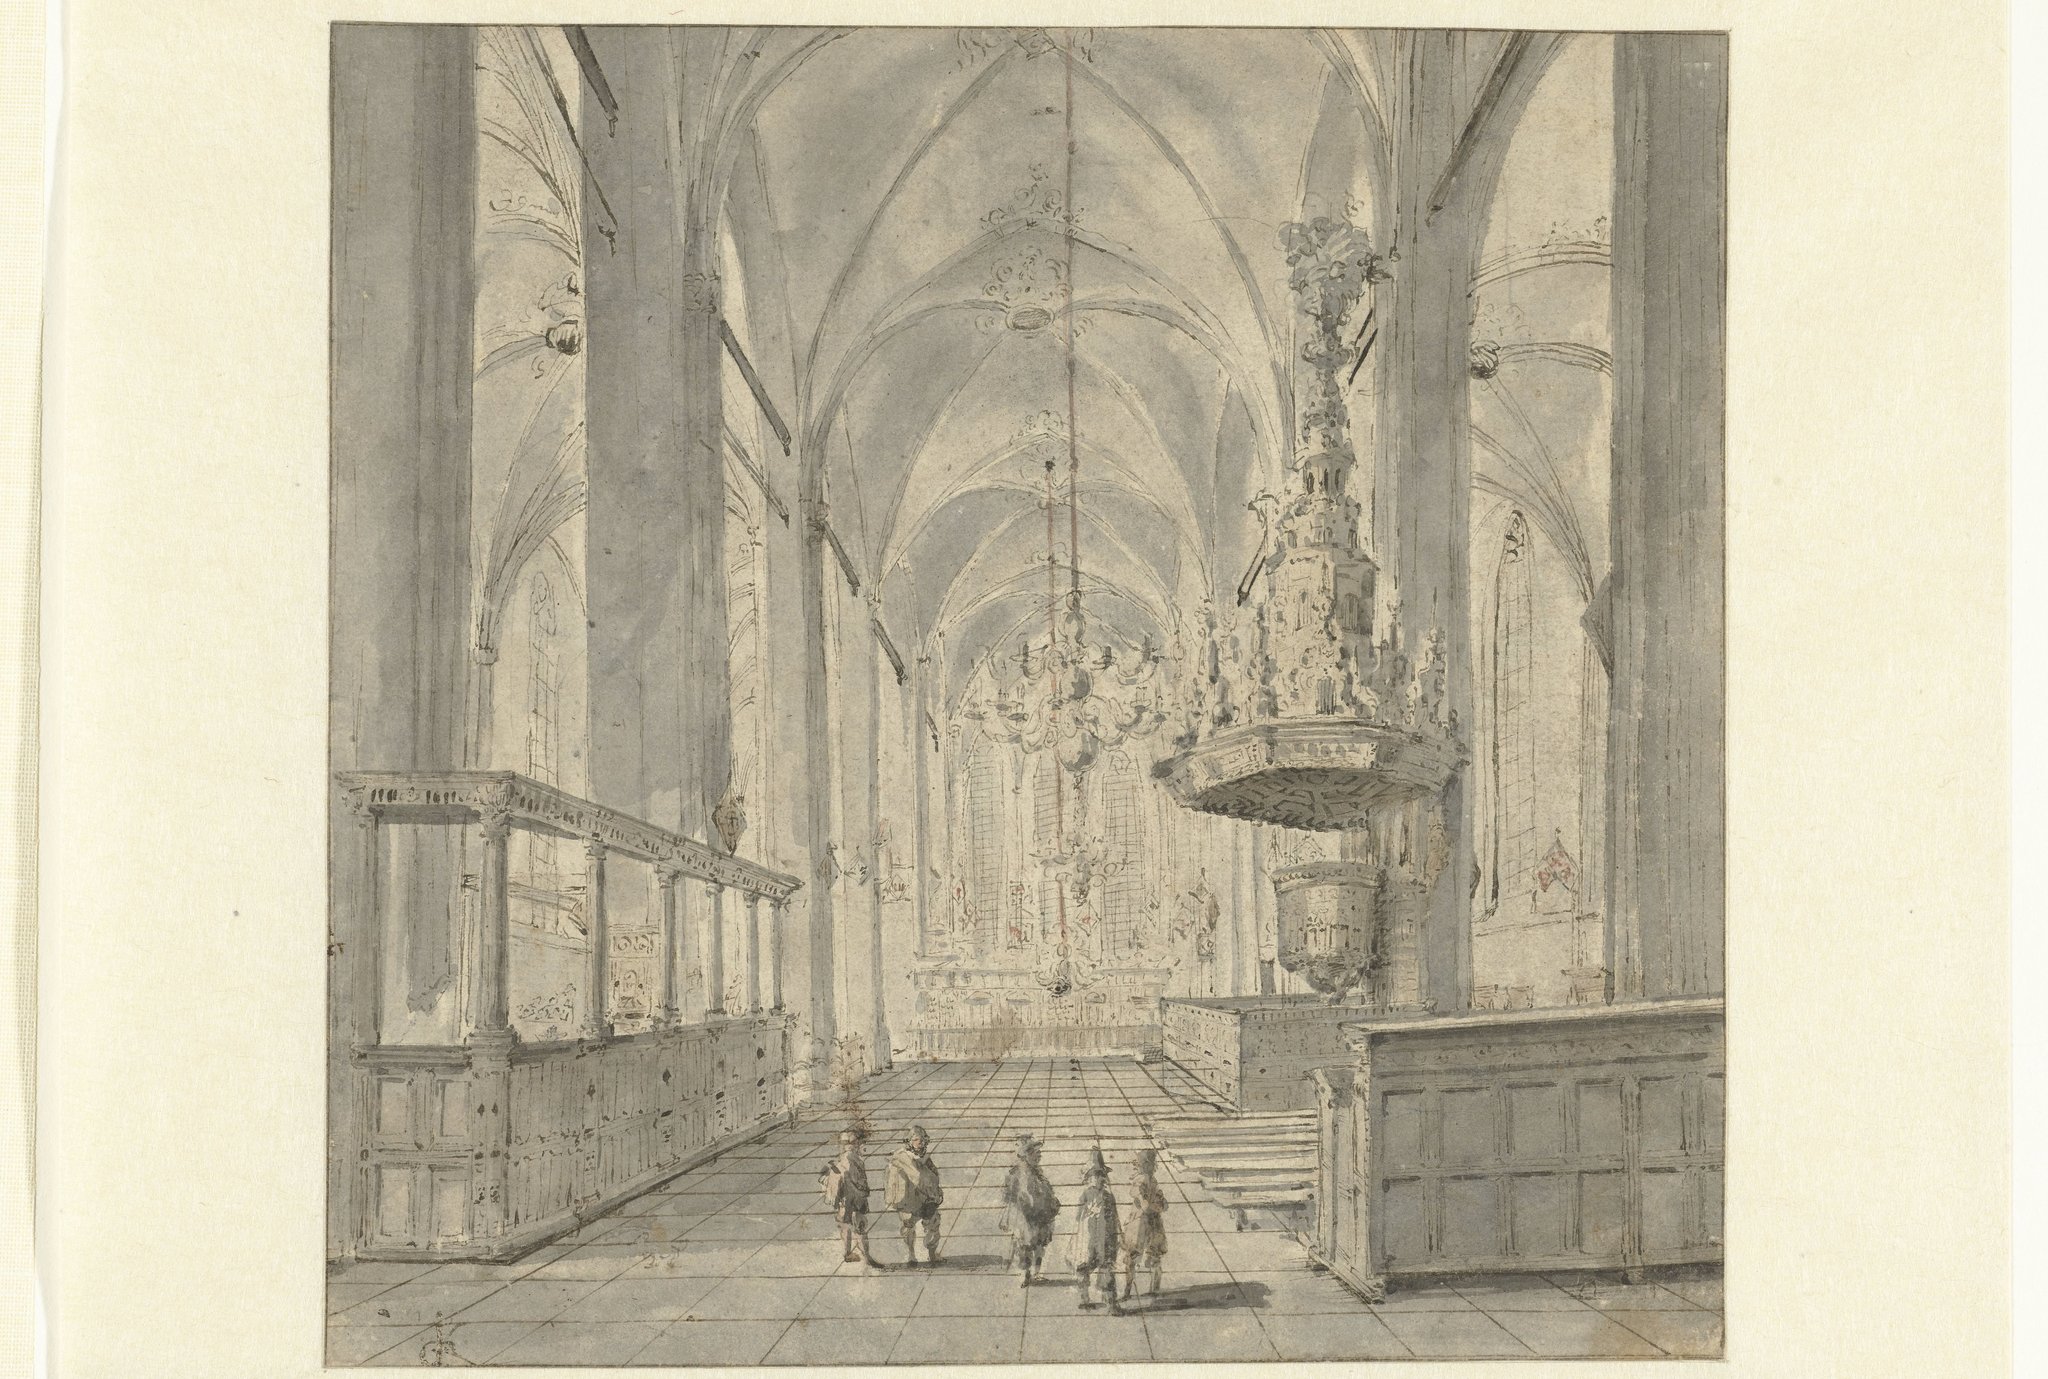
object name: drawing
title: Interieur van de Sint-Michaëlskerk te Zwolle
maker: jan gerritsz van cuylenburg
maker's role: draughtsman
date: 1600-1699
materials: ink, paper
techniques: brush, pen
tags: sint-michaëlskerk